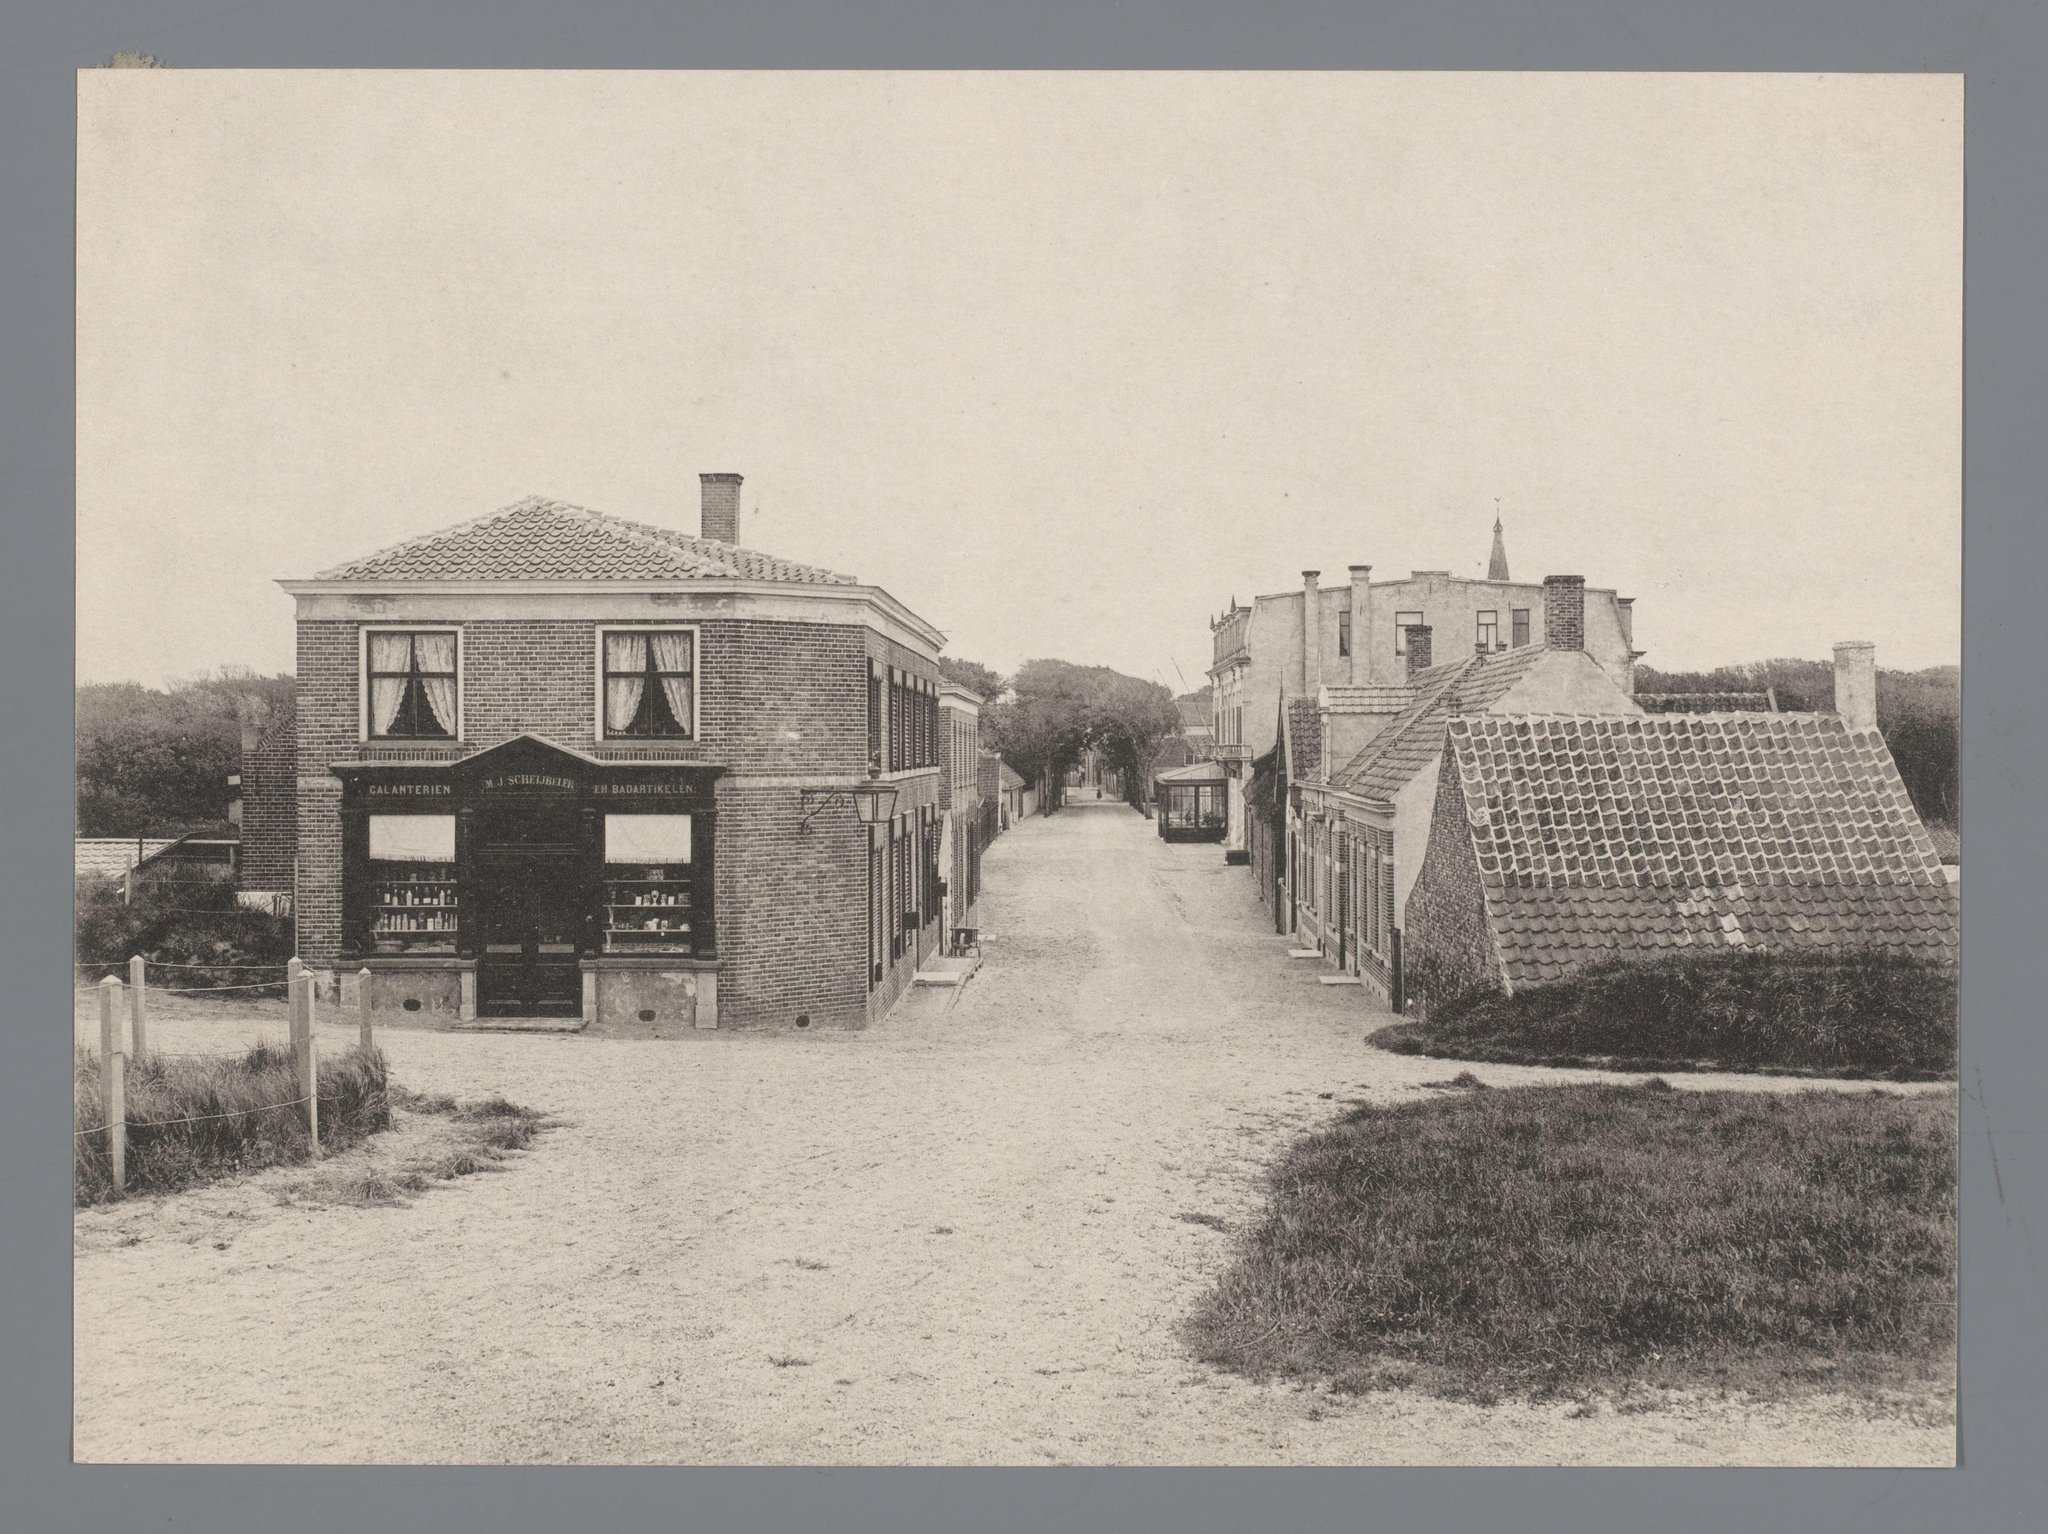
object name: photomechanical print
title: Straatgezicht met de winkel van M.J. Scheijbeler, vermoedelijk te Middelburg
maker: Anonymous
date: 1880-1910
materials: paper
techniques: photograph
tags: shop, store, street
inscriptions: inscription: ‘Vosmaer’